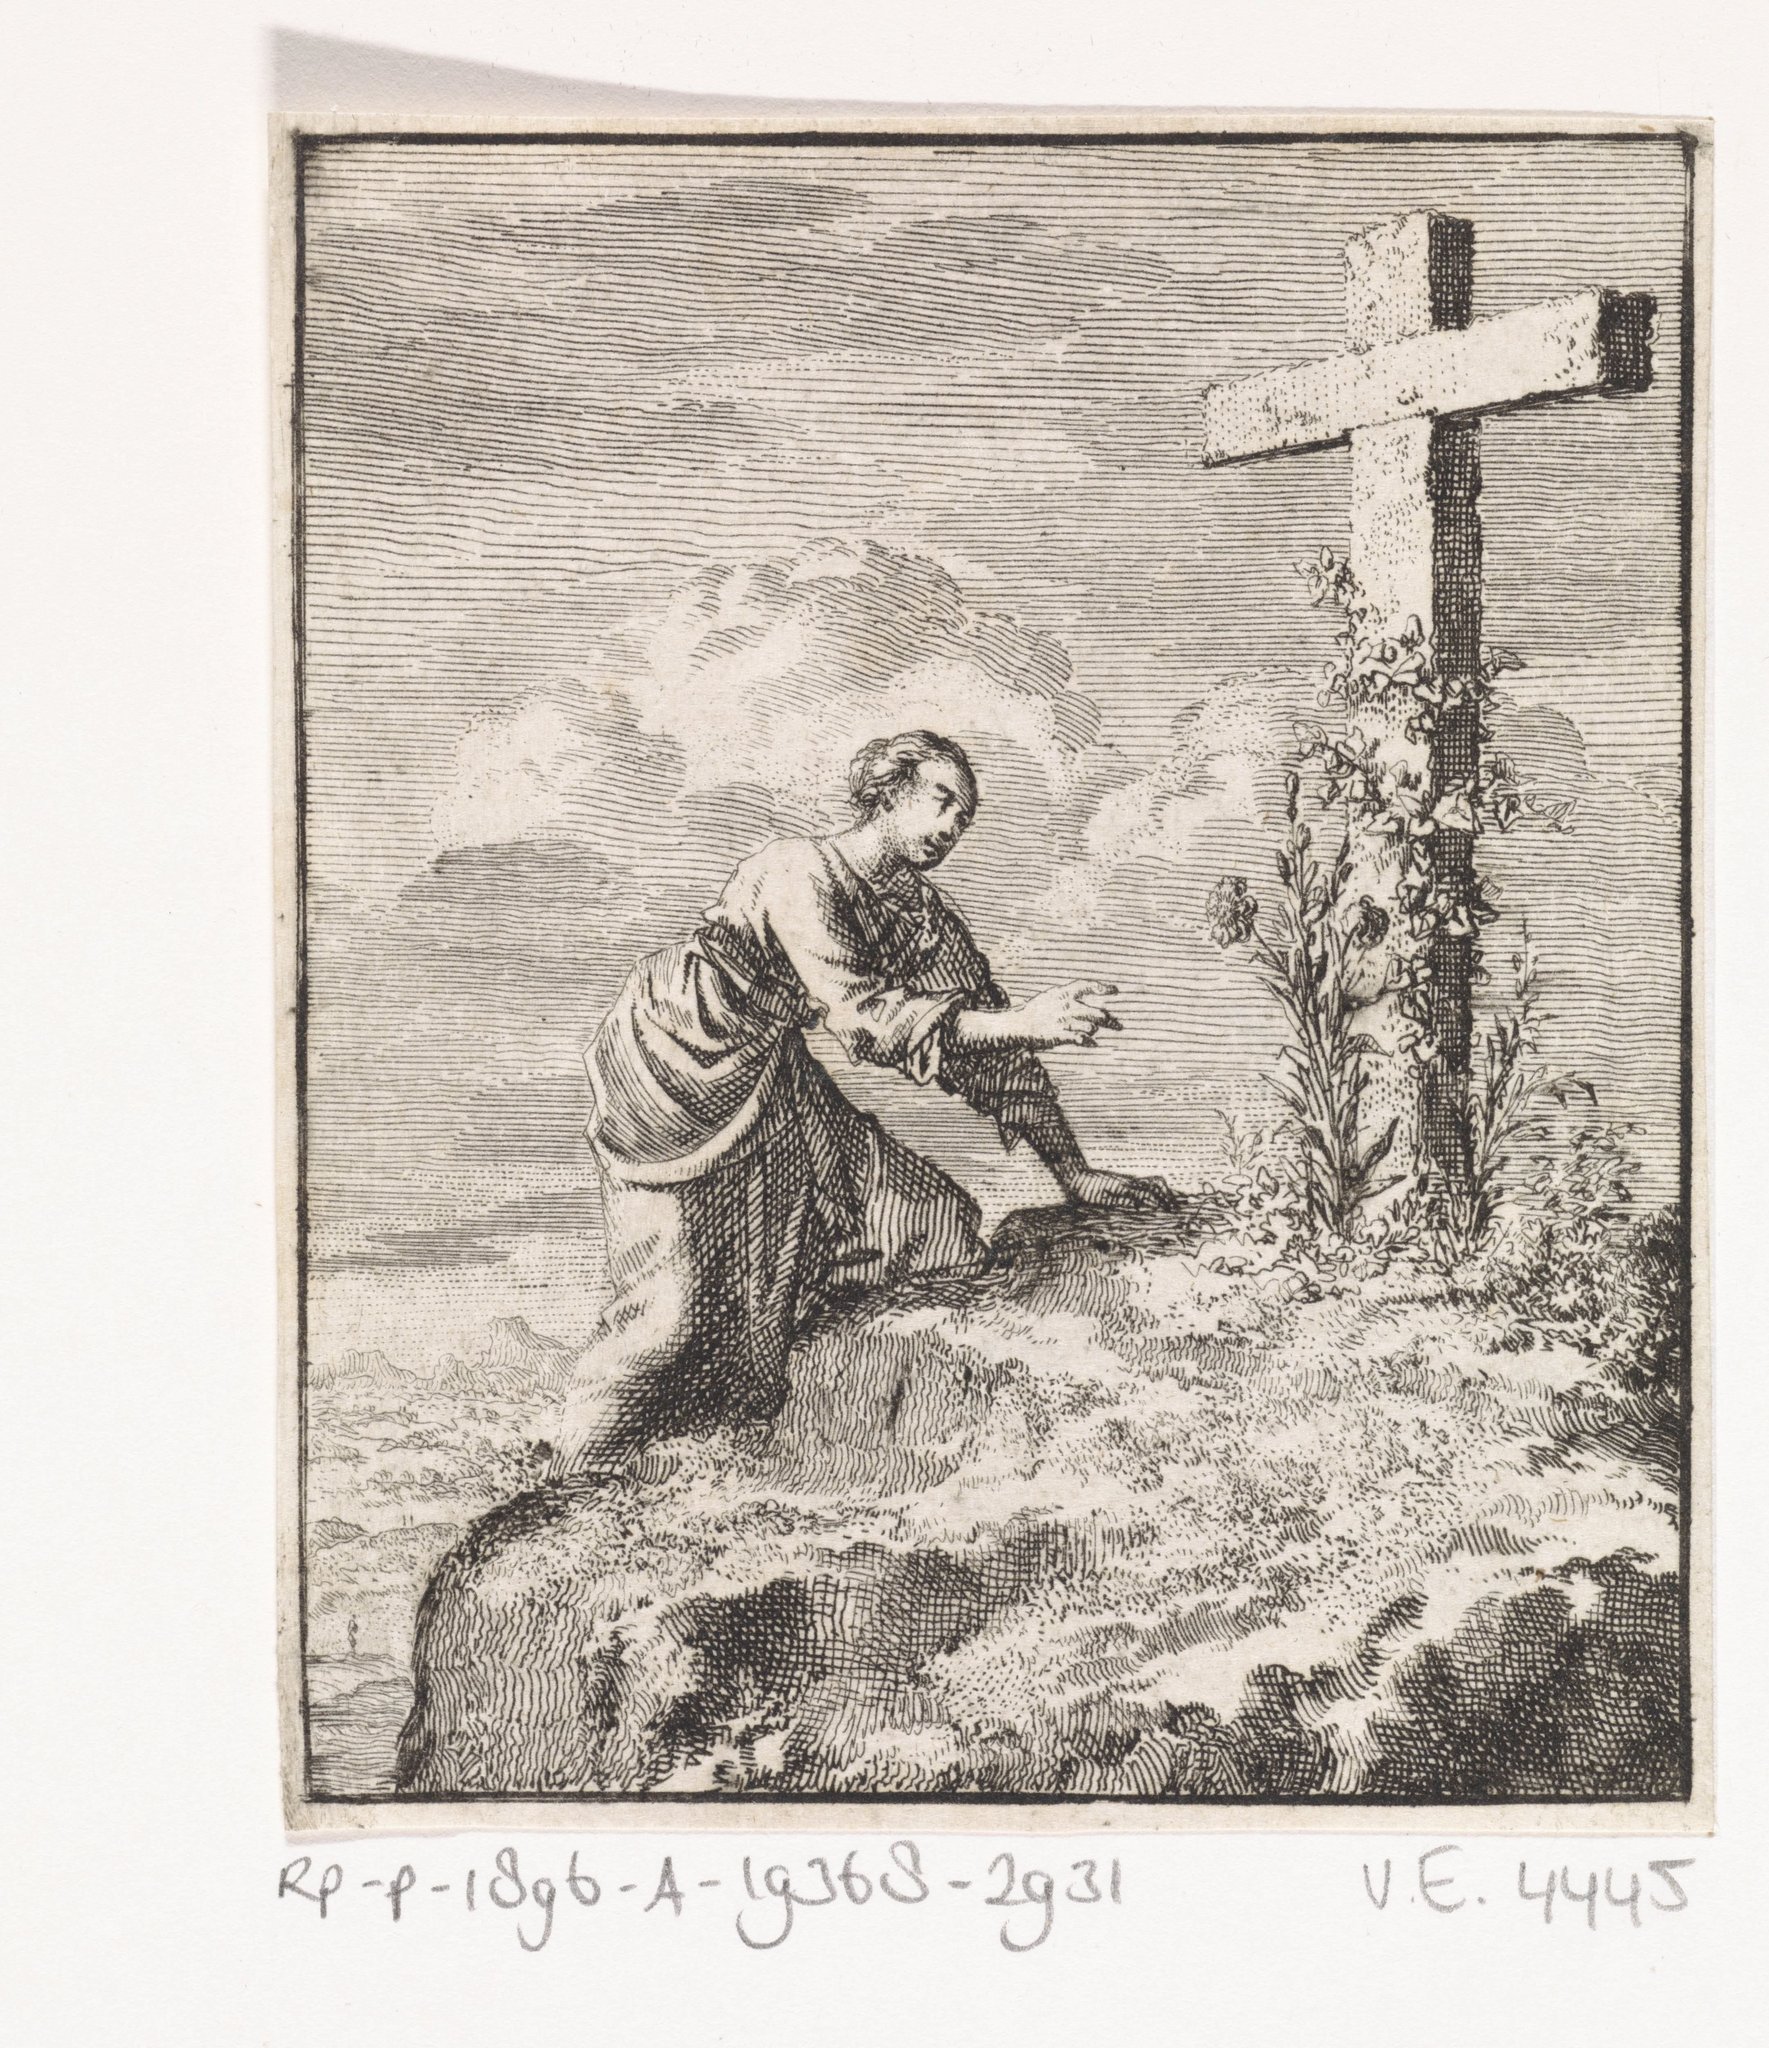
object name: print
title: Gepersonifieerde ziel voor een kruis op een heuvel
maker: jan luyken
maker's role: draughtsman, print maker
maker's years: 1649-1712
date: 1714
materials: paper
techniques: etching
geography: amsterdam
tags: cross as symbol of christ, the soul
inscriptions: collector's mark: Lugt 2228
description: Proefdruk van illustratie uit: Luyken, Jan. Jezus en de Ziel, 3 delen. Amsterdam: Wed. Pieter Arentsz II en Cornelis van der Sys, 1714, dl. I, p. 27.